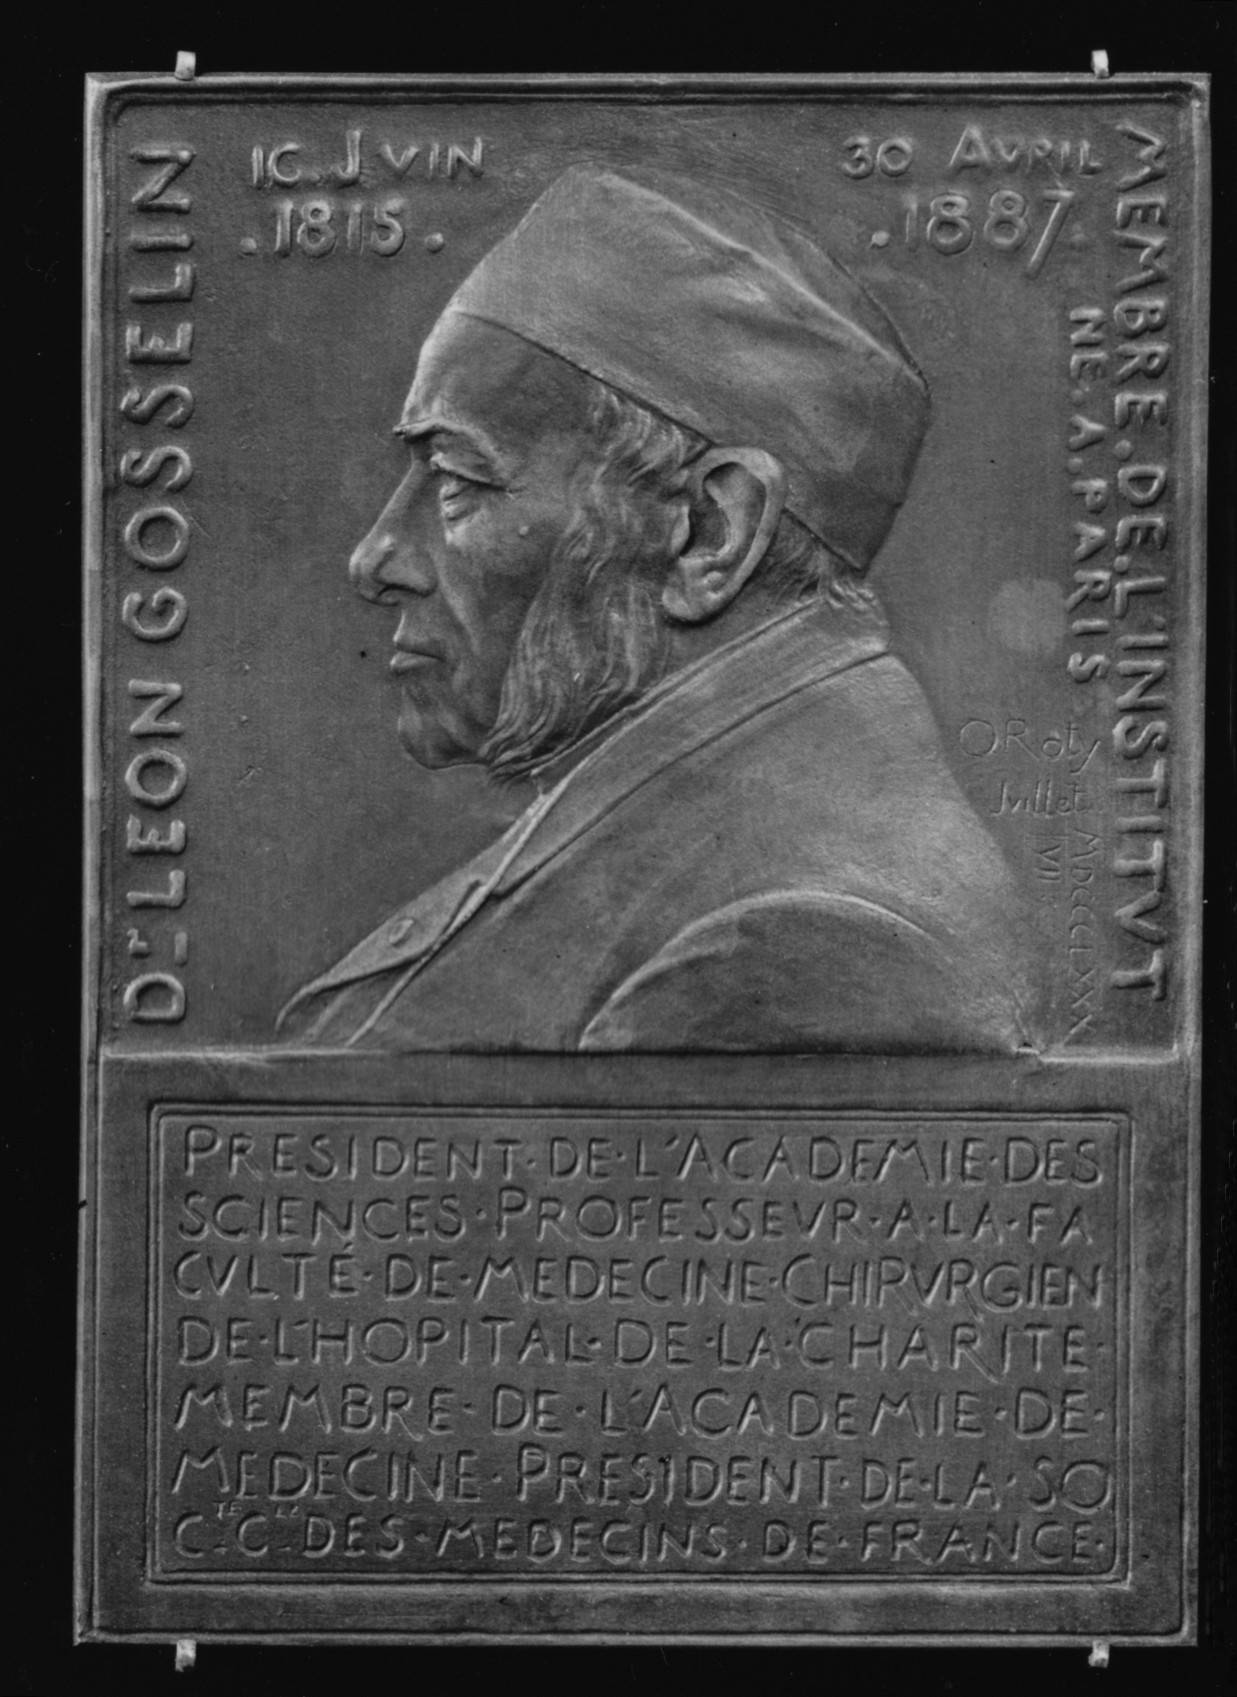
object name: plaquette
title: In Memory of Dr. Leon Gosselin (1815–1887), President of the Academy of Sciences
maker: louis-oscar roty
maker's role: artist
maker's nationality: french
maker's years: 1846-1911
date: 1888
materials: silver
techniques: struck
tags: men,profiles